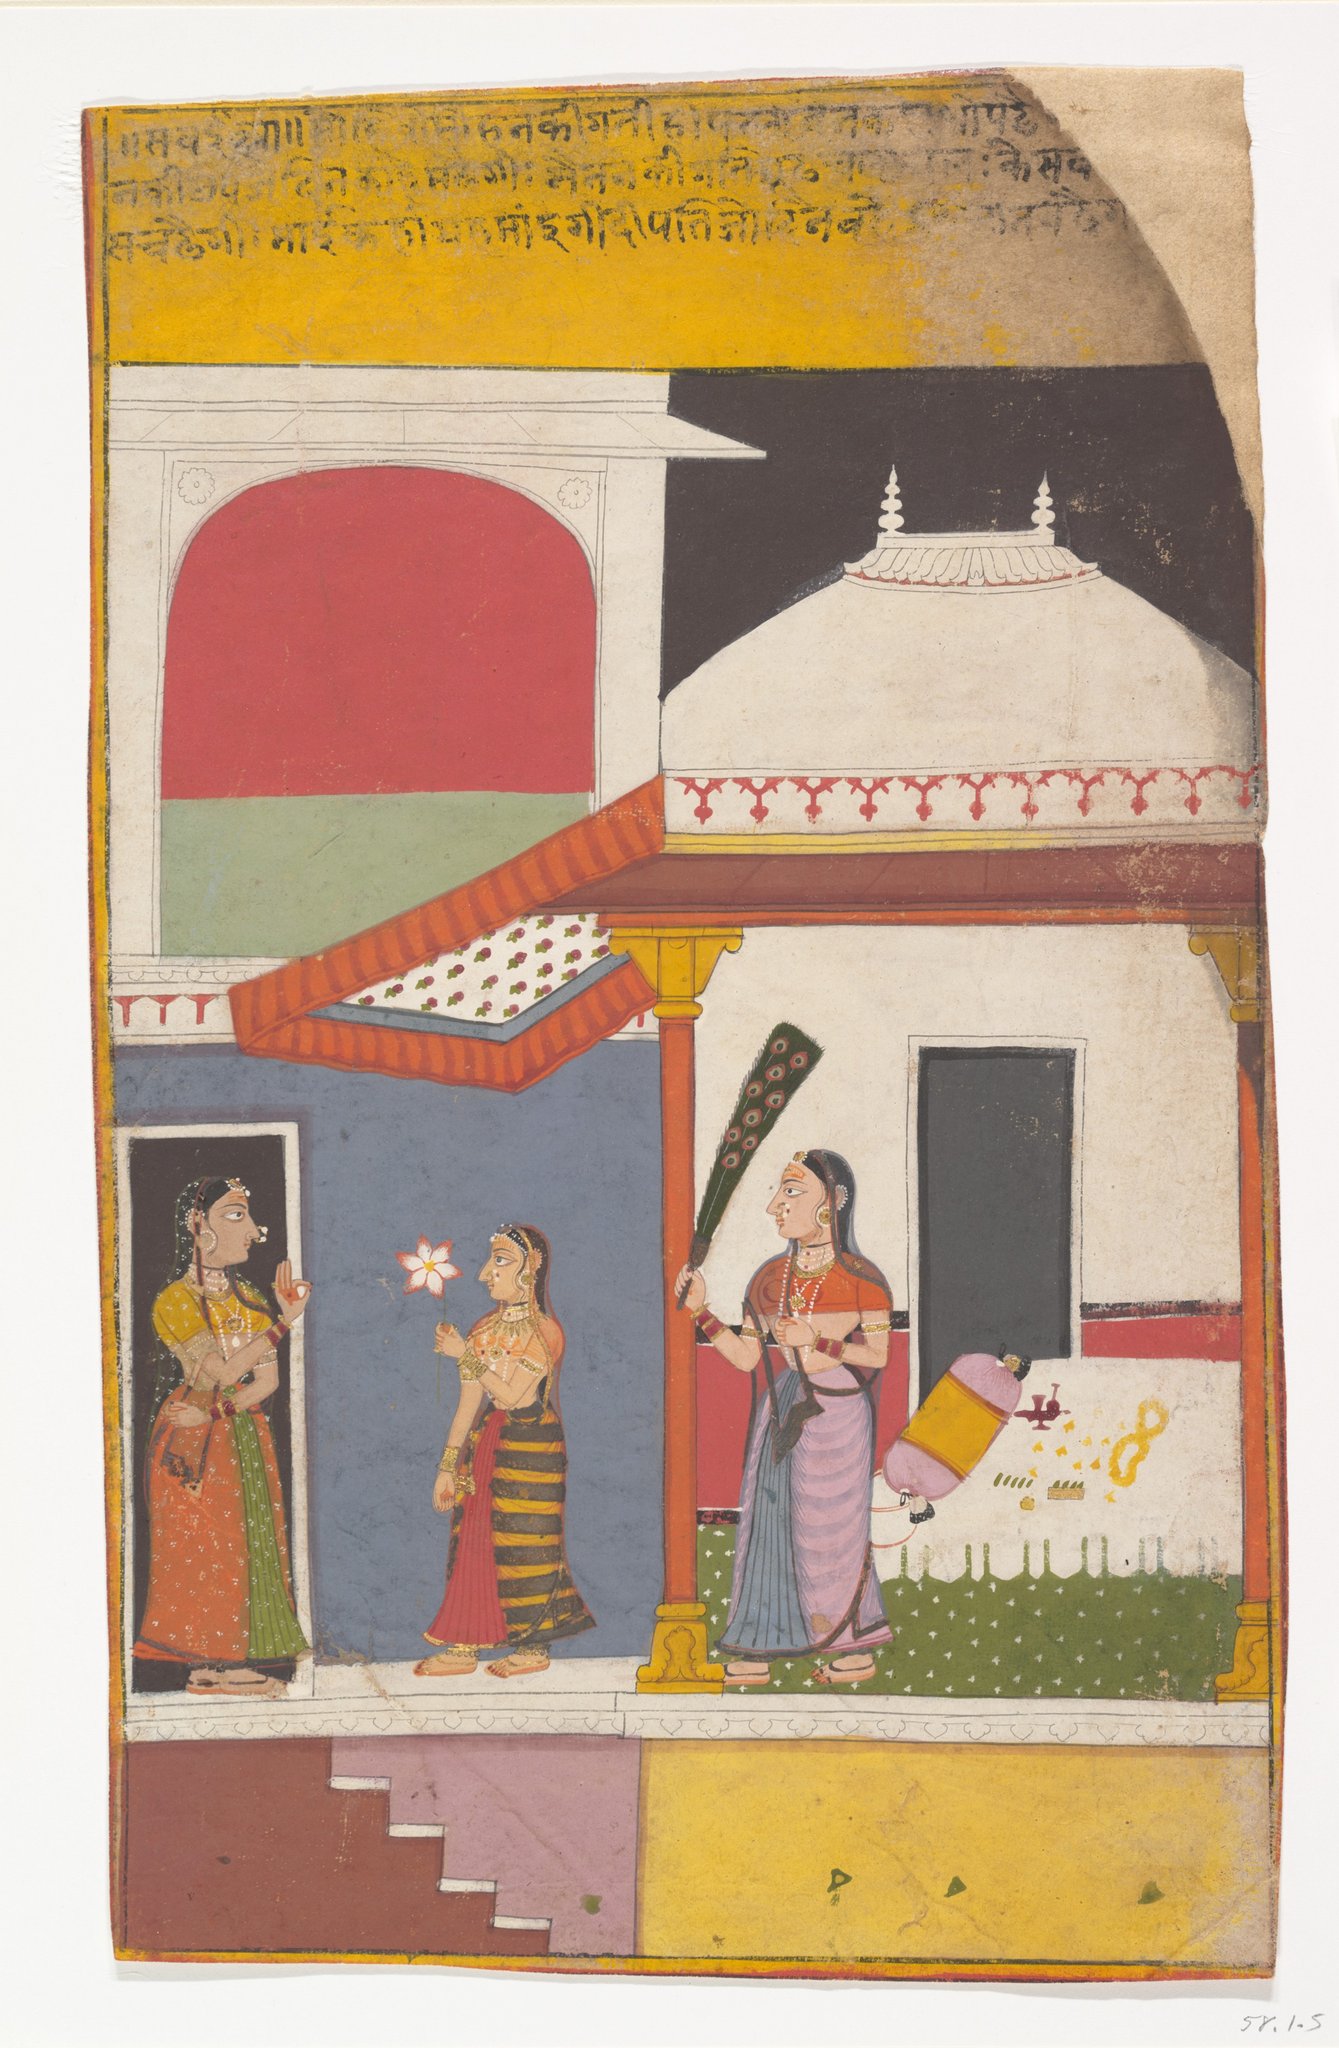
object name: folio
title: Page from a Dispersed Ragamala Series (Garland of Musical Modes)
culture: mewar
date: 1710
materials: ink, paper, watercolor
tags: women